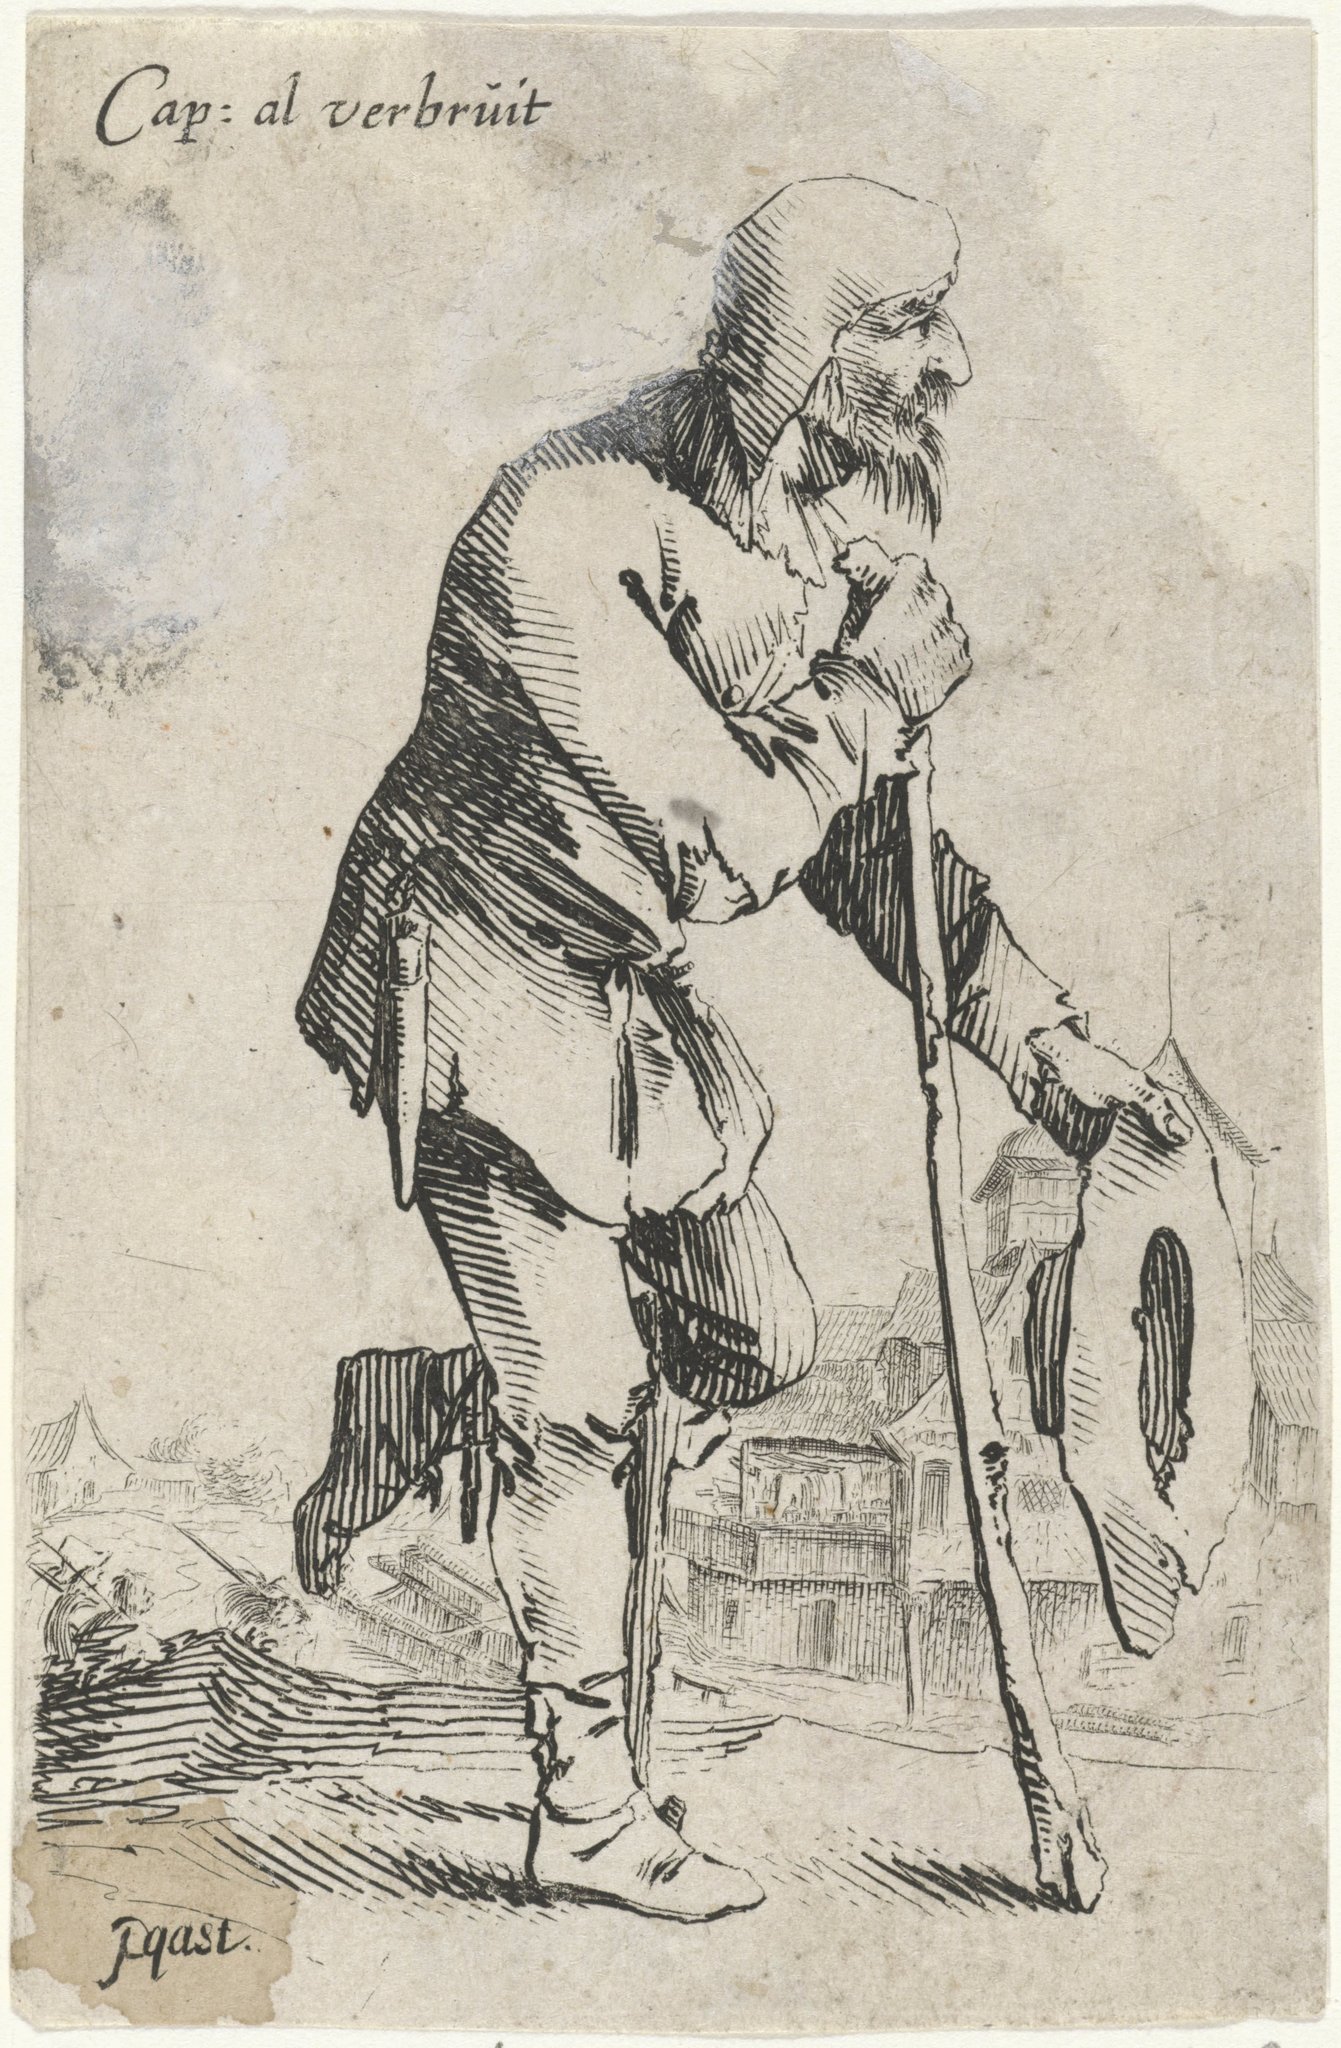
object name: print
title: T'Leven Der Boeren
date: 1630-1665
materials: paper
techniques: engraving, etching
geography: amsterdam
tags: crutches, walking-stick, staff, person with a physical disability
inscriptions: collector's mark: Lugt 240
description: Zie tevens de vijf overgeleverde spiegelbeeldige kopieën naar deze serie door Reinhard Voskens.